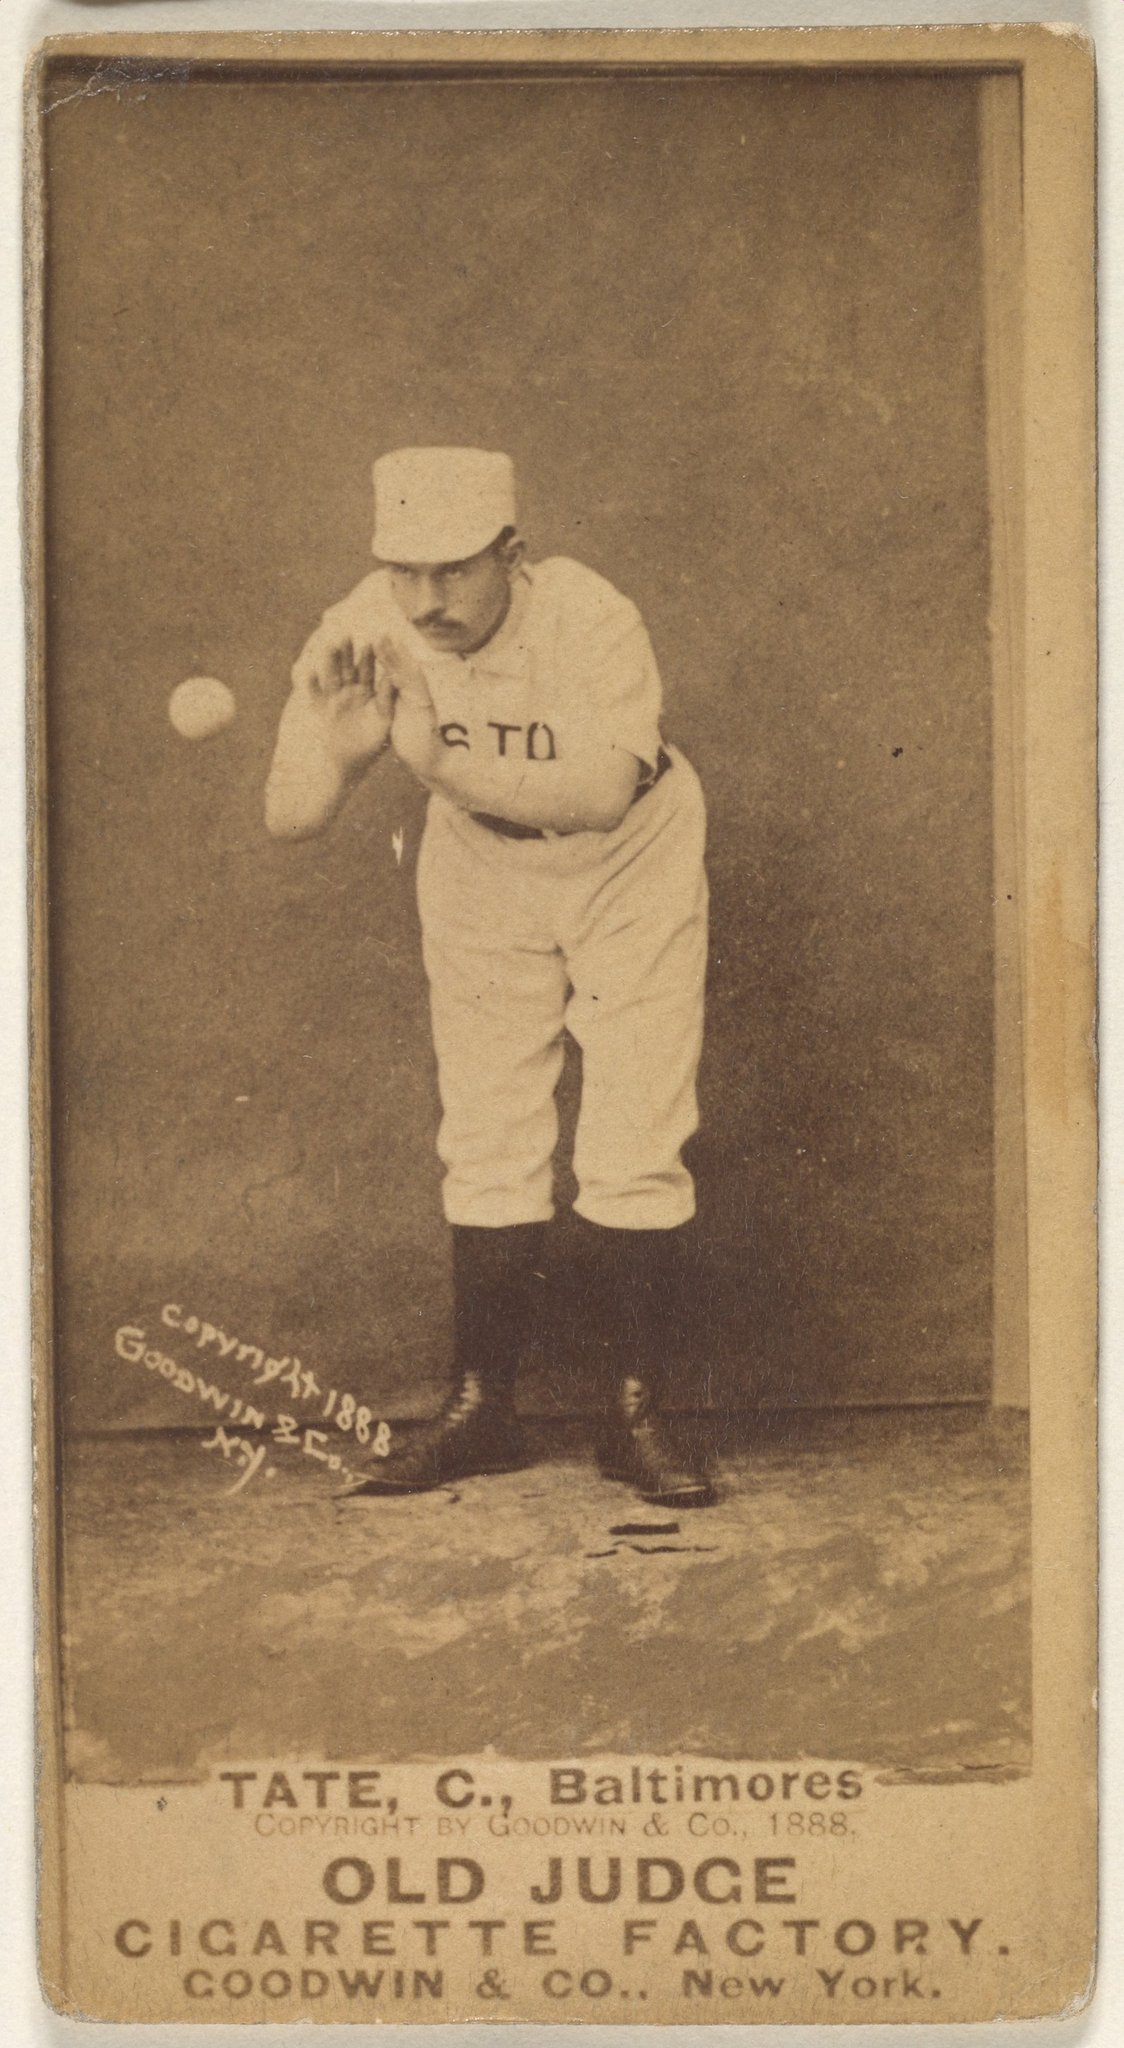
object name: baseball card, photograph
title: Tate, Catcher, Baltimore Orioles, from the Old Judge series (N172) for Old Judge Cigarettes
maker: goodwin & company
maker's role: publisher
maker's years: 1850-1950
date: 1888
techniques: albumen silver print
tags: men,portraits,baseball,athletes